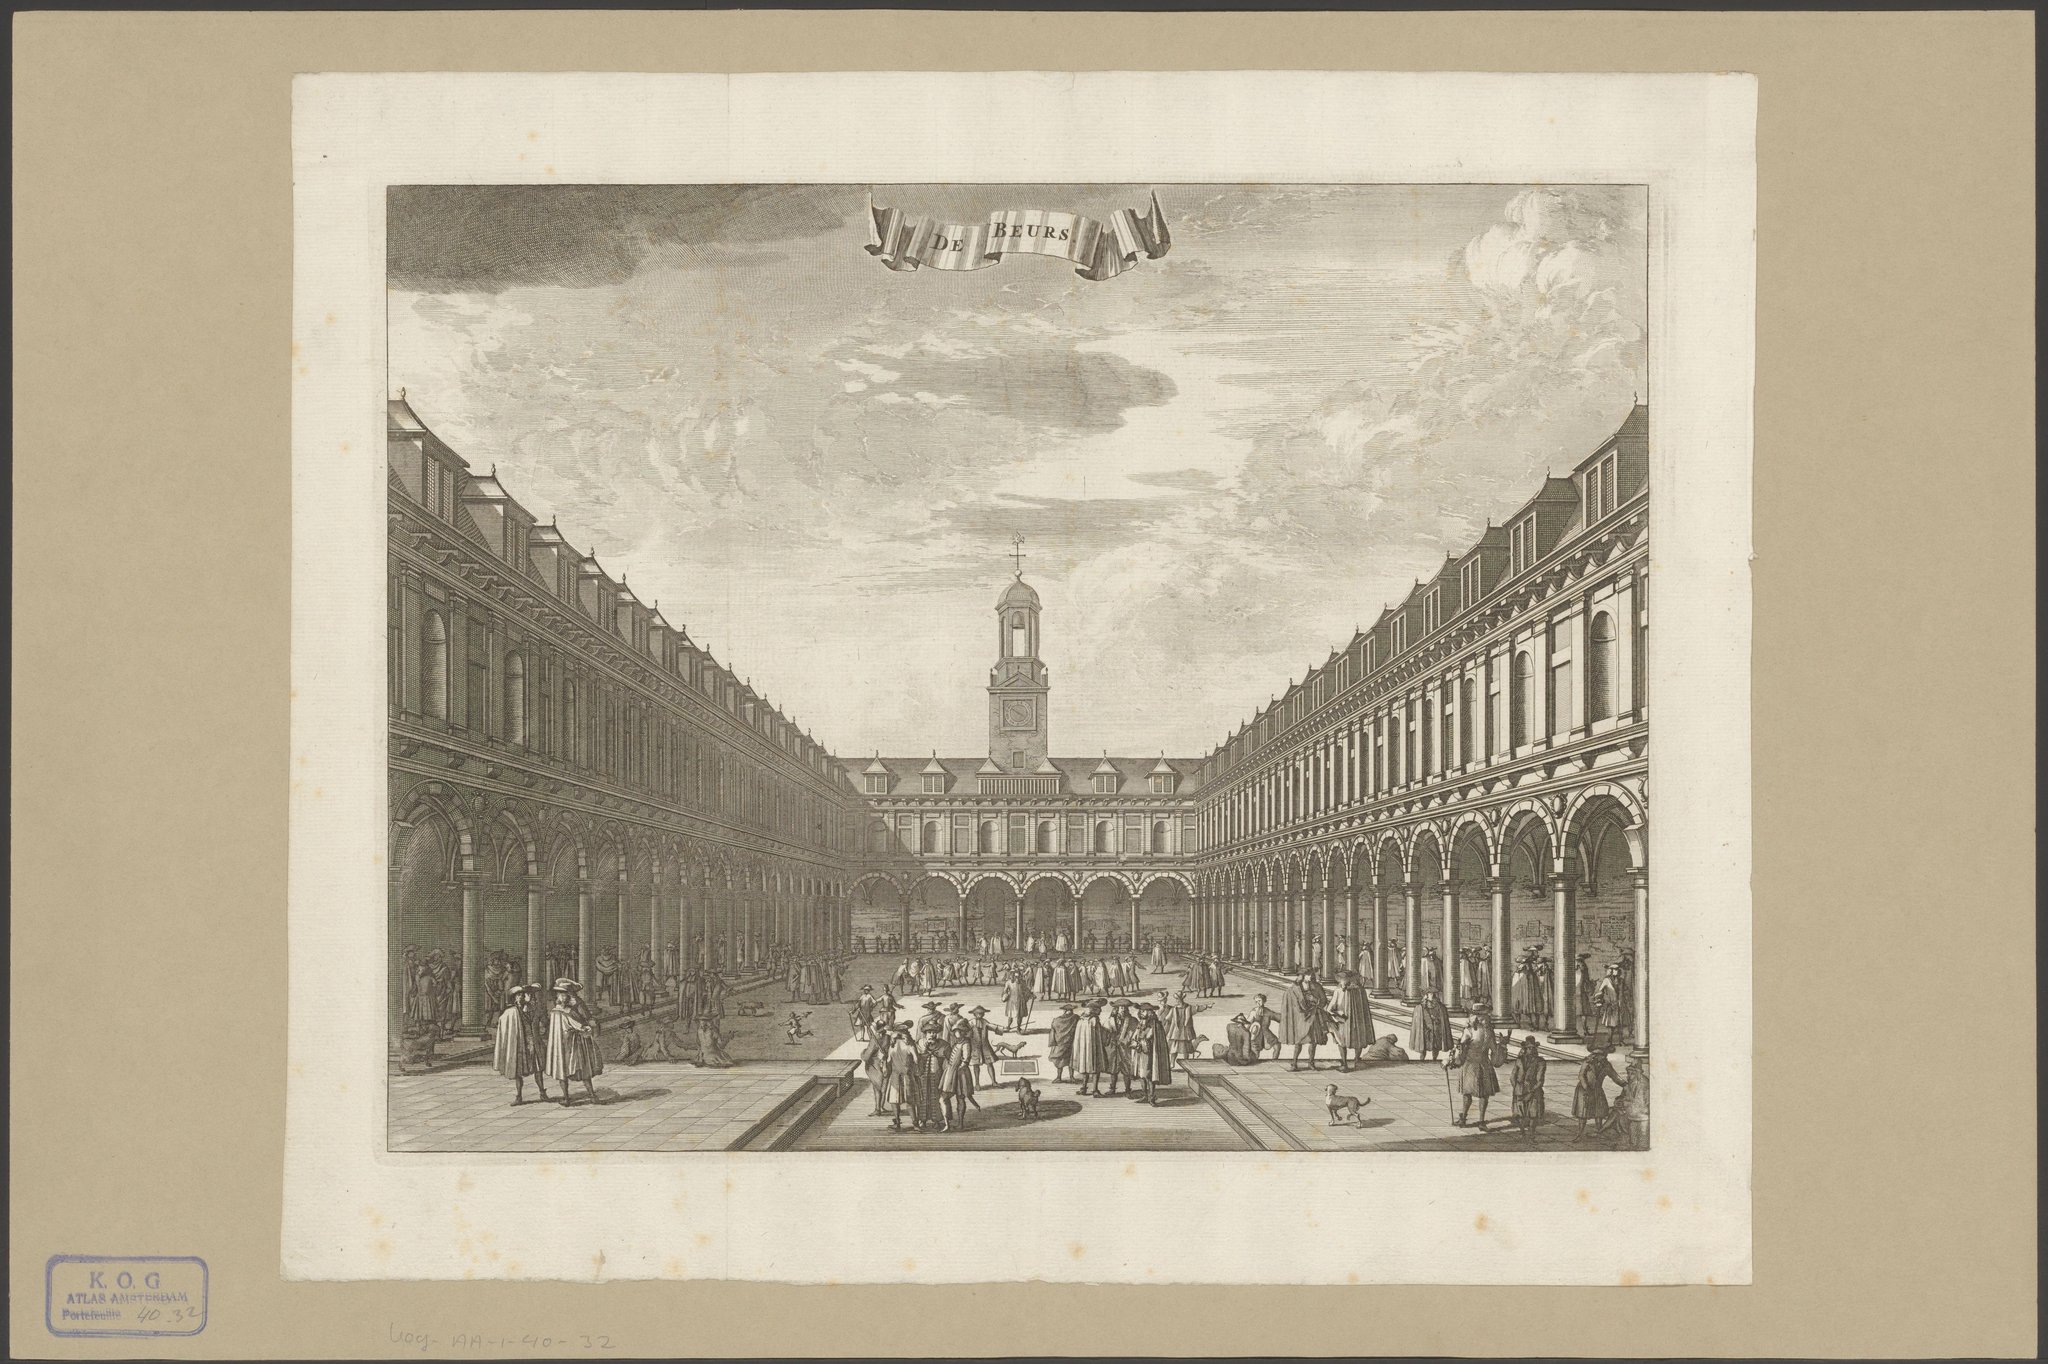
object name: print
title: Gezicht op de binnenplaats van de Beurs van Hendrik de Keyser te Amsterdam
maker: Anonymous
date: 1726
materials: paper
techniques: engraving, etching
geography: northern netherlands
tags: stock exchange, stock-market, courtyard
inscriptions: collector's mark: Lugt 1641b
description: Huidige staat van prent ook gebruikt in: Commelin, Casparus. Beschryvinge van Amsterdam (…). 2de druk. Amsterdam: Andries van Damme, Johannes Ratelband, weduwe Antony van Aeltwijk en Hermanus Uytwerf, 1726, dl. 2. Eerste staat van prent (zonder opgewerkte lucht en extra figuren) ook gebruikt in: Commelin, Casparus. Beschryvinge van Amsterdam (…). Amsterdam: Abraham Wolfgang, Gillis Janssonius van Waesberge of Johannes Janssonius van Waesberge, Hendrick Boom of weduwe Dirk Boom, Abraham van Sanderen en Rembertus Goethals, 1693, dl. 2. En in: Commelin, Casparus. Beschryvinge van Amsterdam (…). Amsterdam: weduwe Aart Dircksz. Oossaan, 1694, dl. 2.